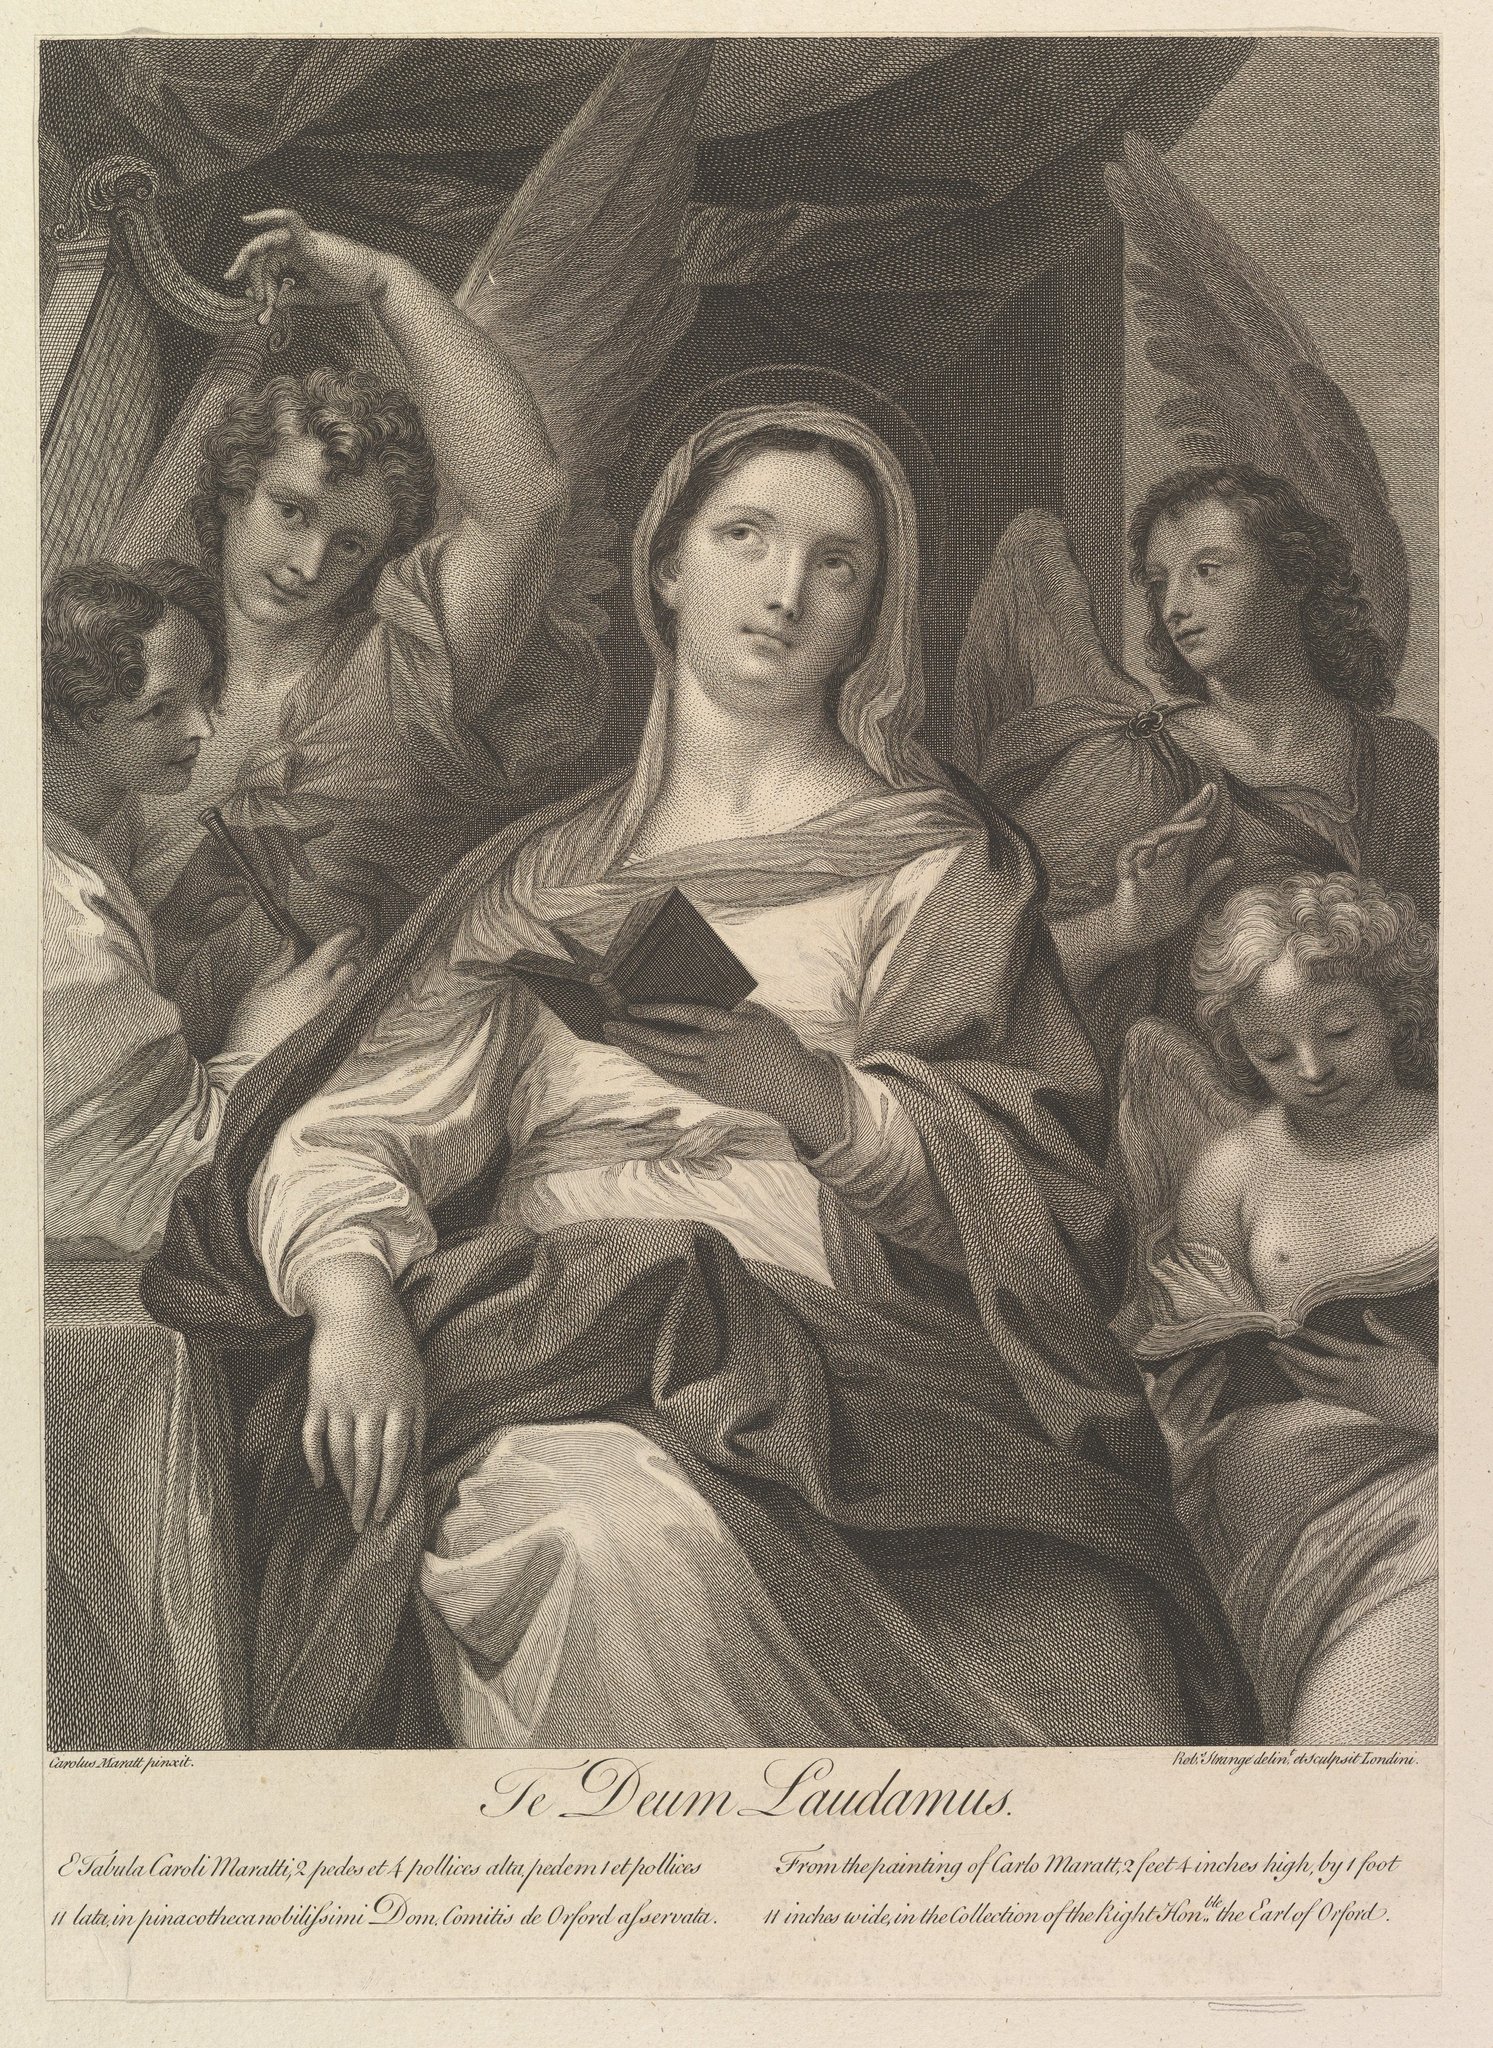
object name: print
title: Te Deum Laudamus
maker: robert strange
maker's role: engraver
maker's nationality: british, scottish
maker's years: 1721-1792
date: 1765-1769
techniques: engraving, etching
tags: angels,virgin mary